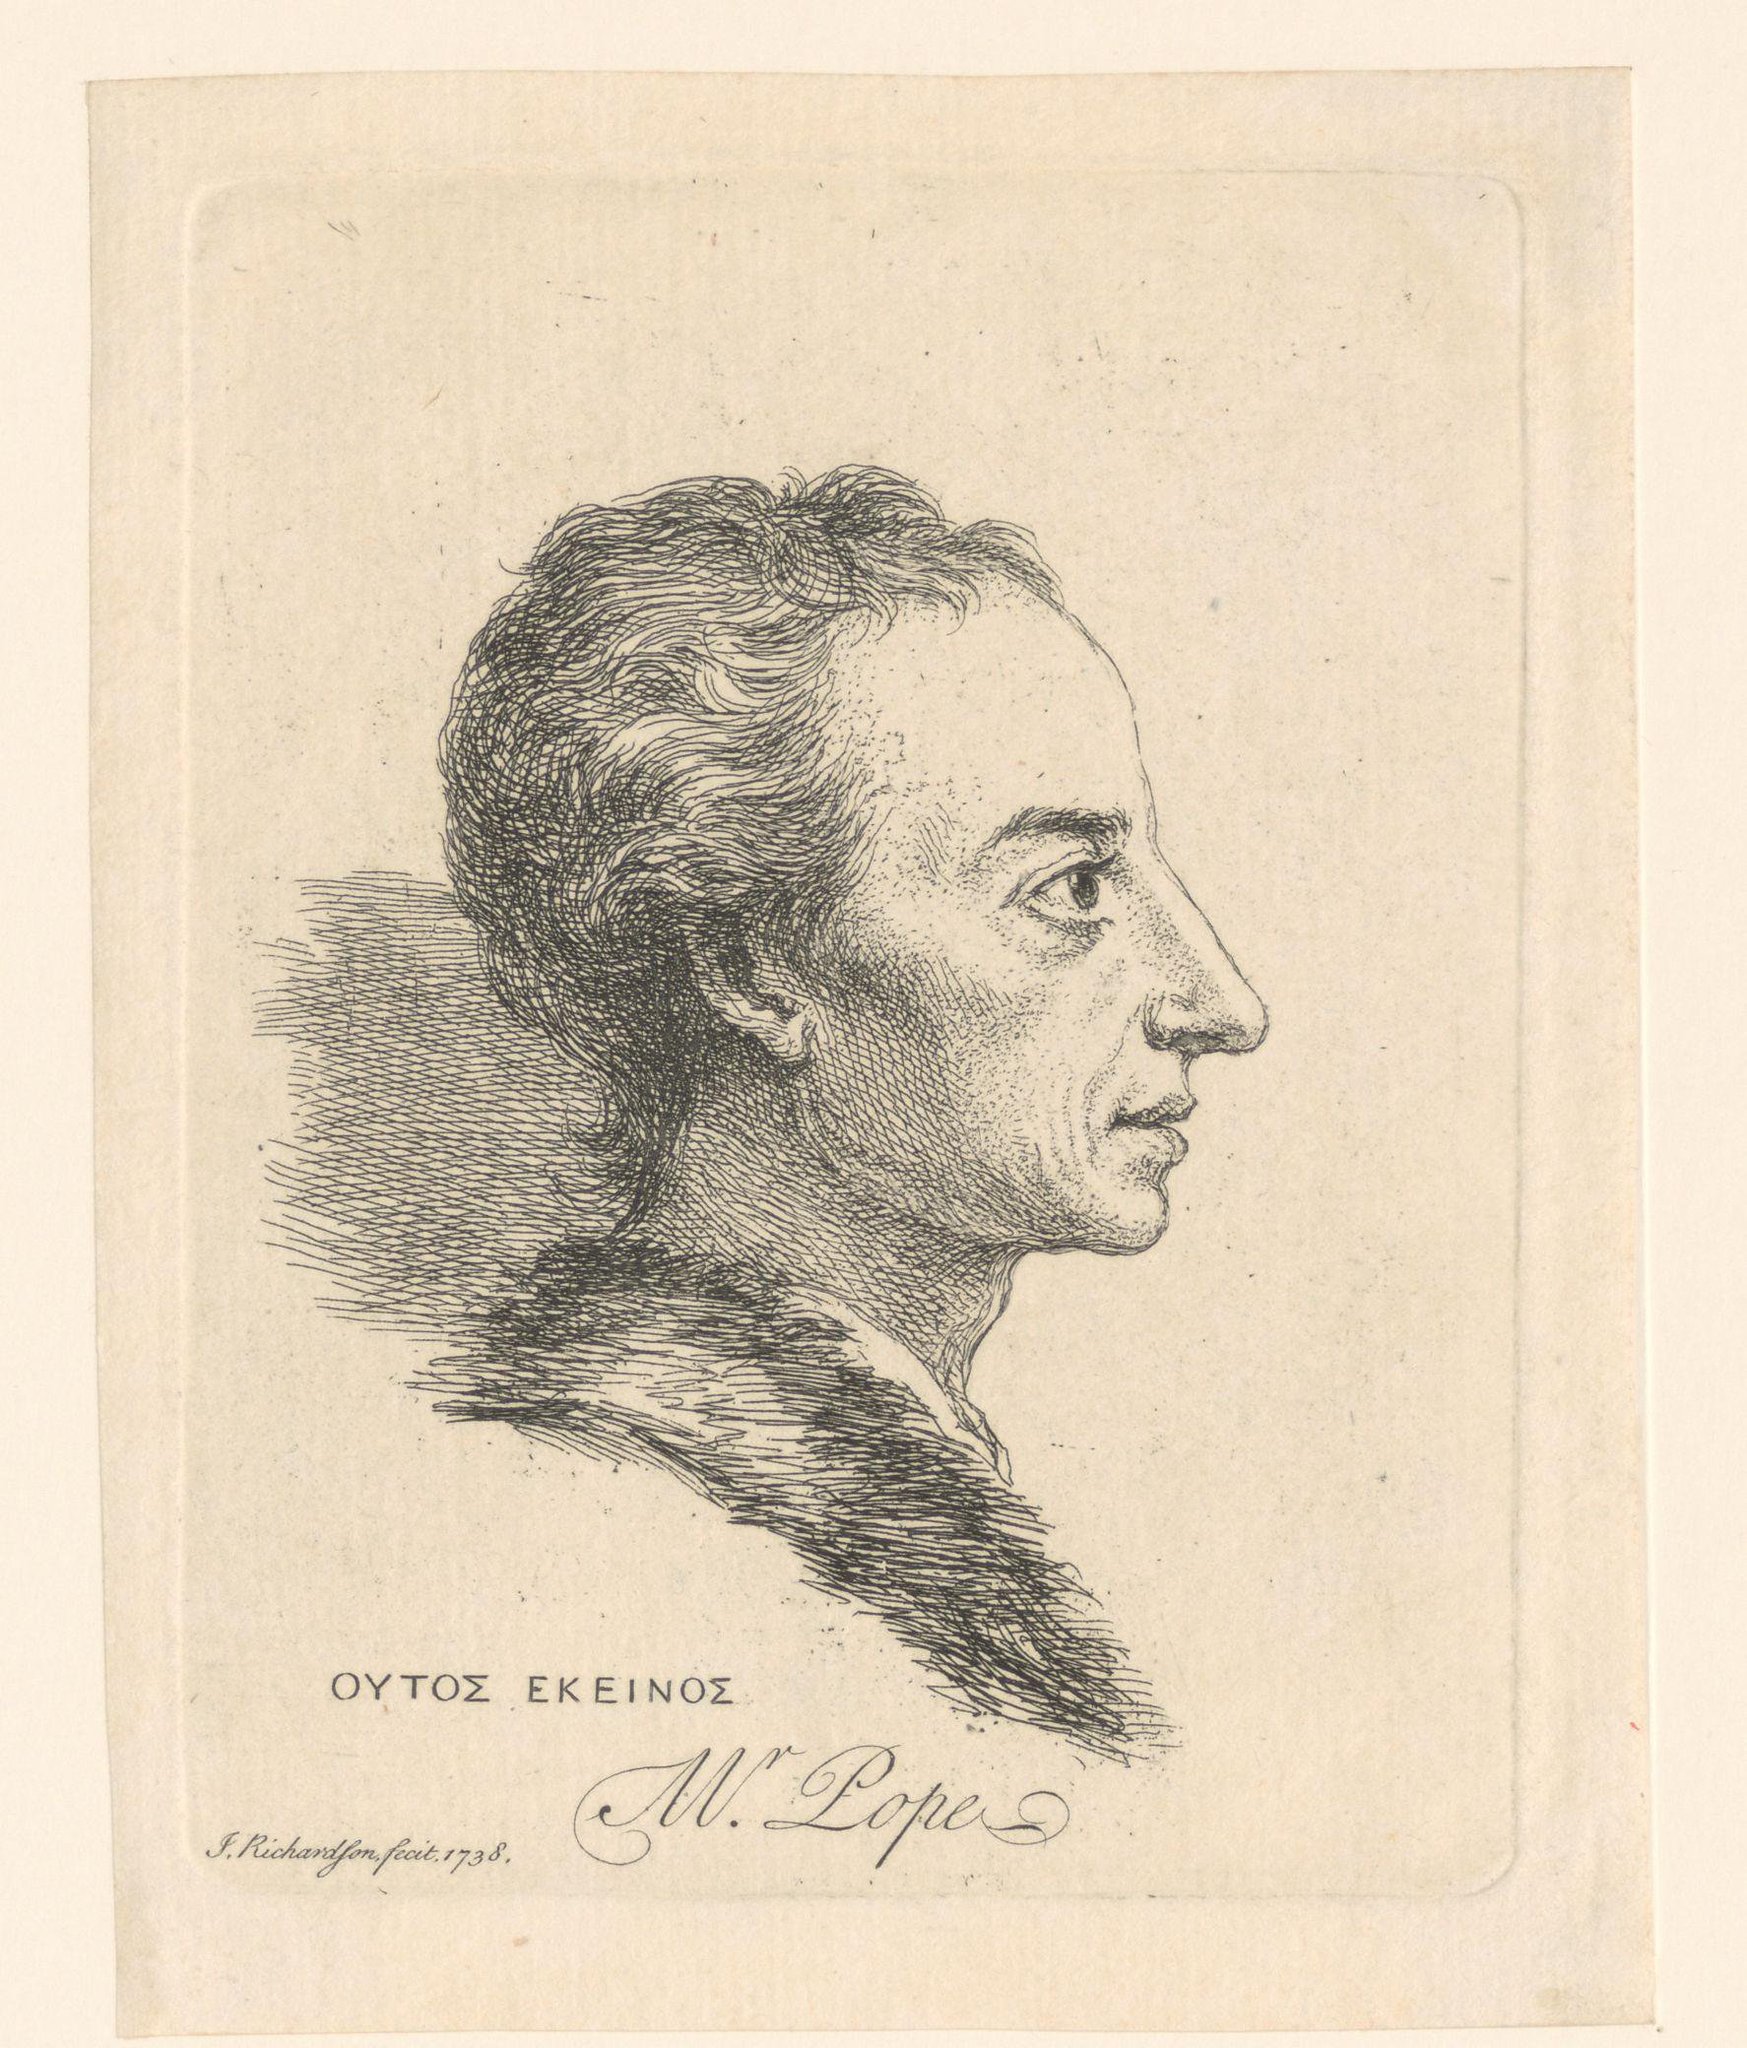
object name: print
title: Portret van Alexander Pope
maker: jonathan richardson (i)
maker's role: draughtsman, print maker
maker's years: 1667-1745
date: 1738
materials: paper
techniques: etching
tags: london, alexander pope, historical persons, writer, poet, author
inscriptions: collector's mark: Lugt 2228, collector's mark: Lugt 2760